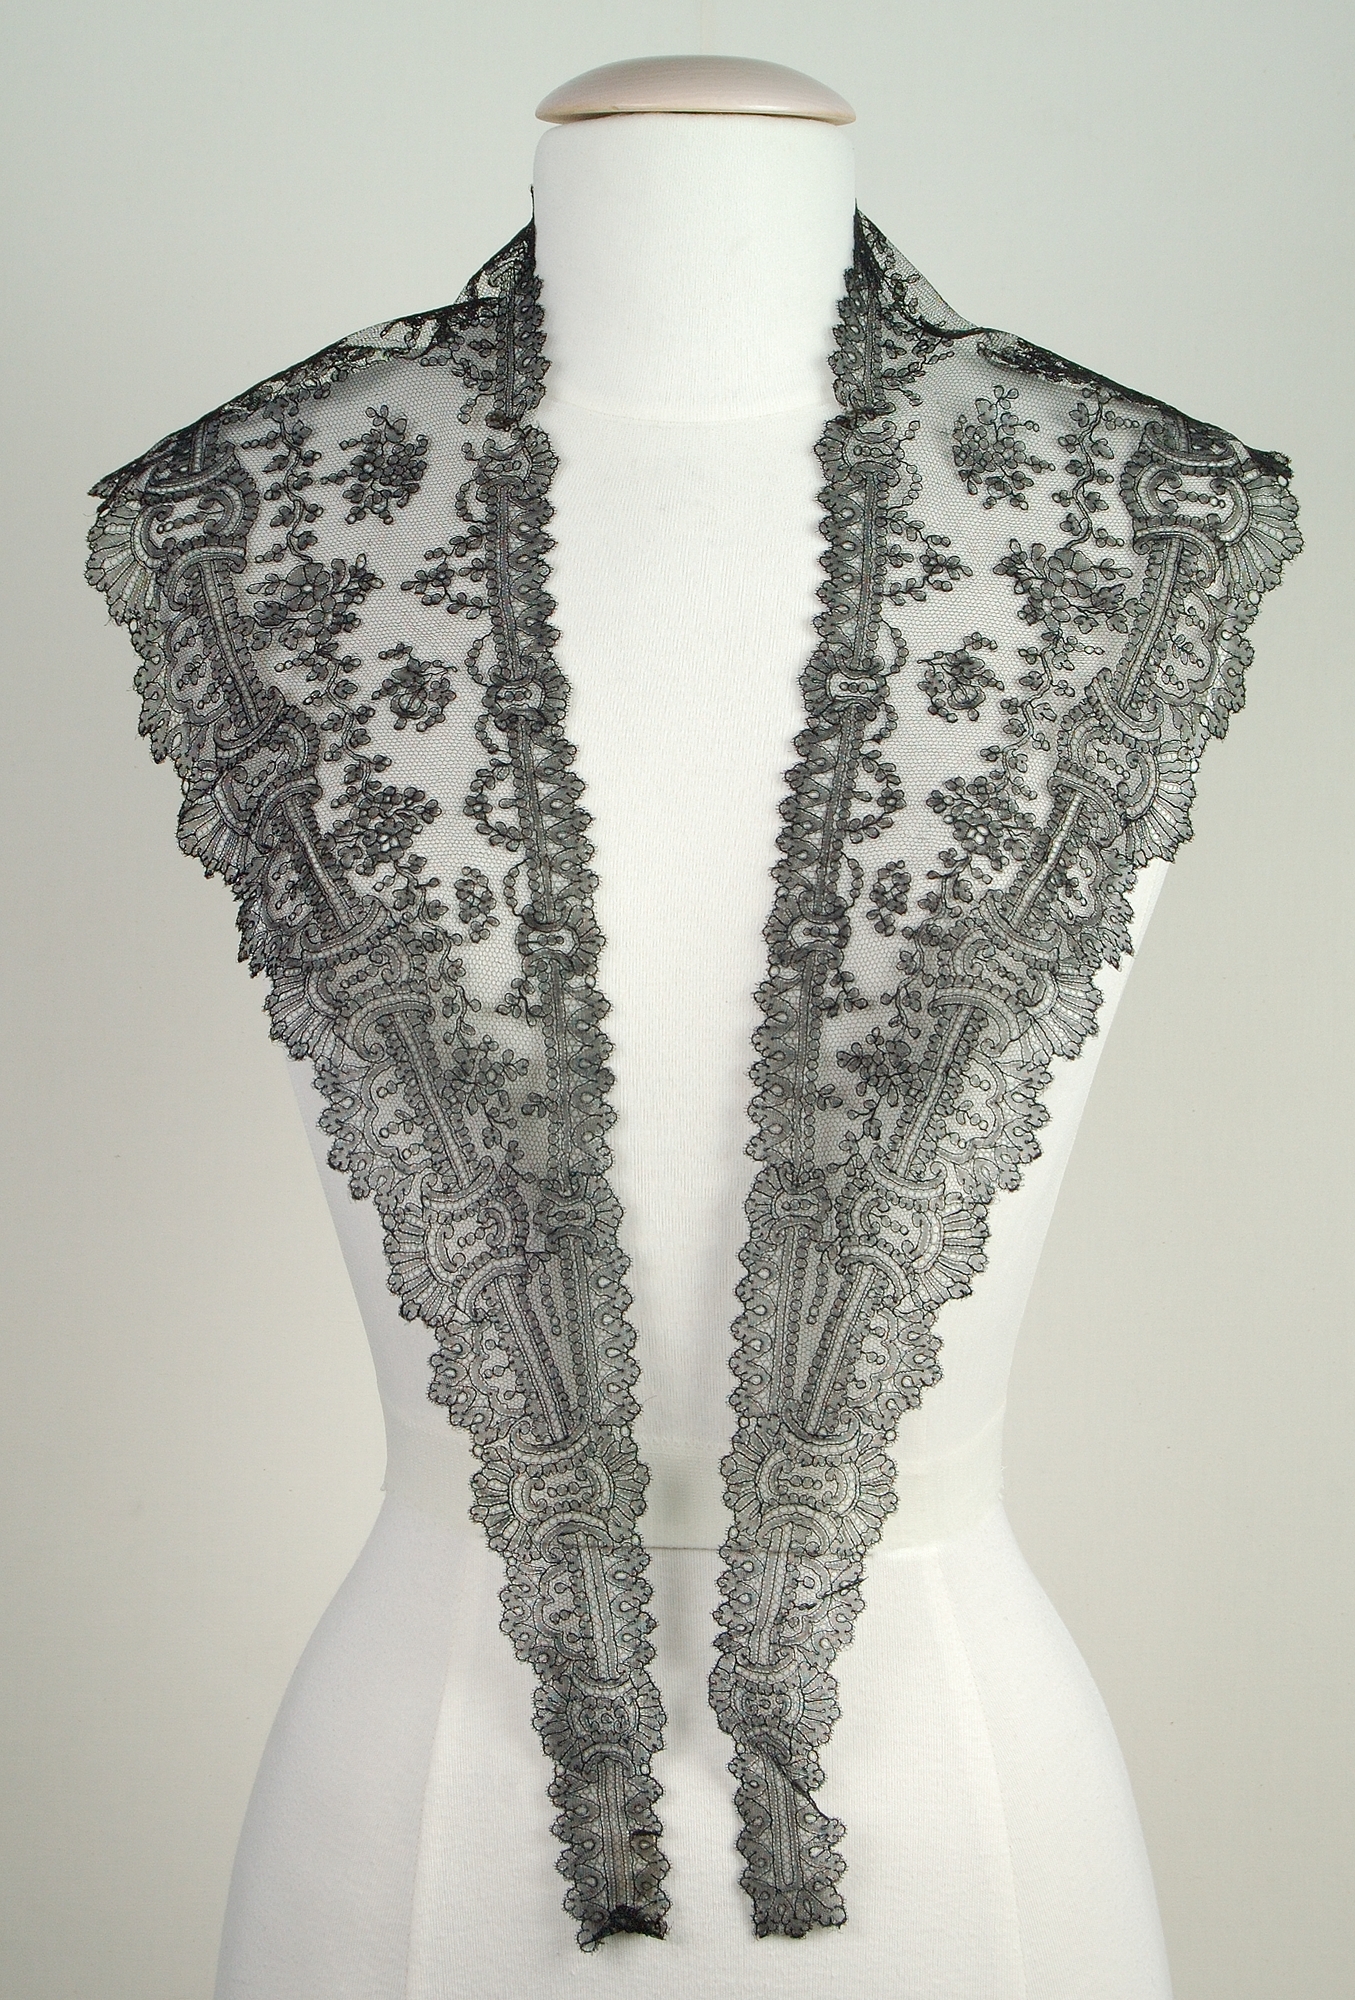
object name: fichu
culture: french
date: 1834-1866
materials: silk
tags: flowers